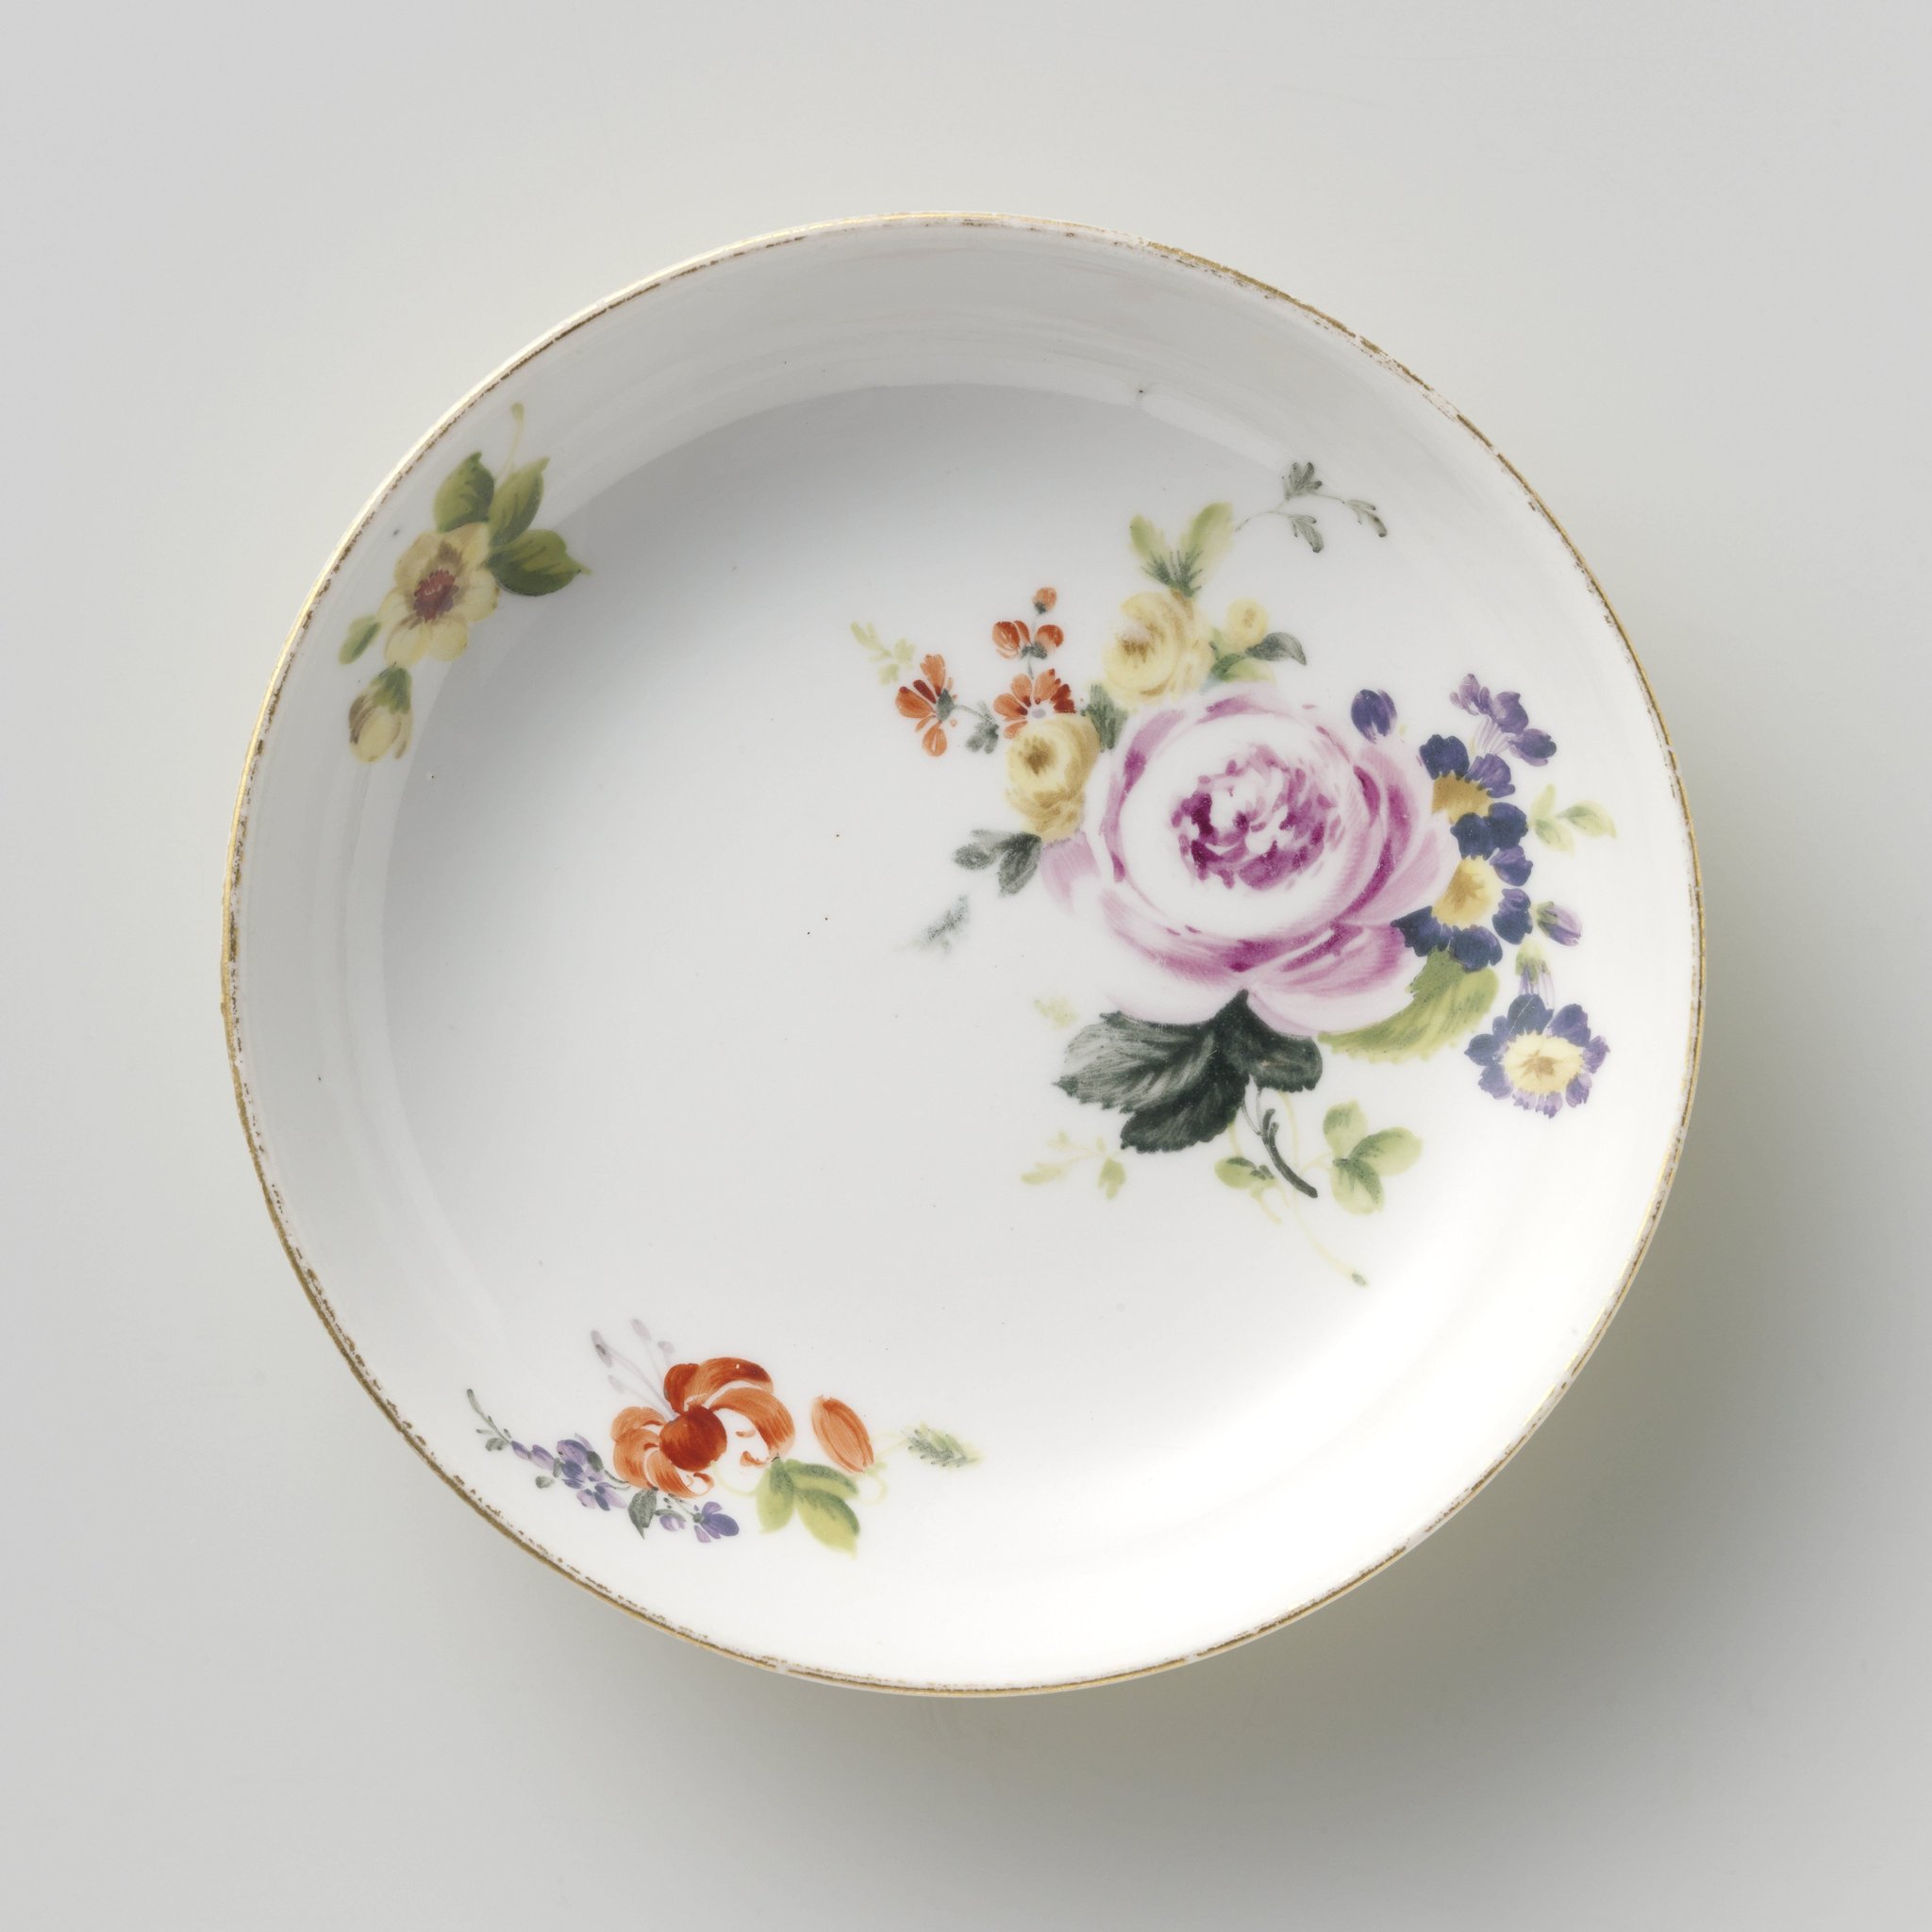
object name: platter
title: Schotel, veelkleurig beschilderd met Deutsche Blumen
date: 1765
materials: porcelain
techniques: painted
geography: meissen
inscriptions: mold mark, factory mark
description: Tea service. Porcelain. Meissen, c. 1770. Jonkvrouwe A.C.A.J. Clifford bequest, 1960.